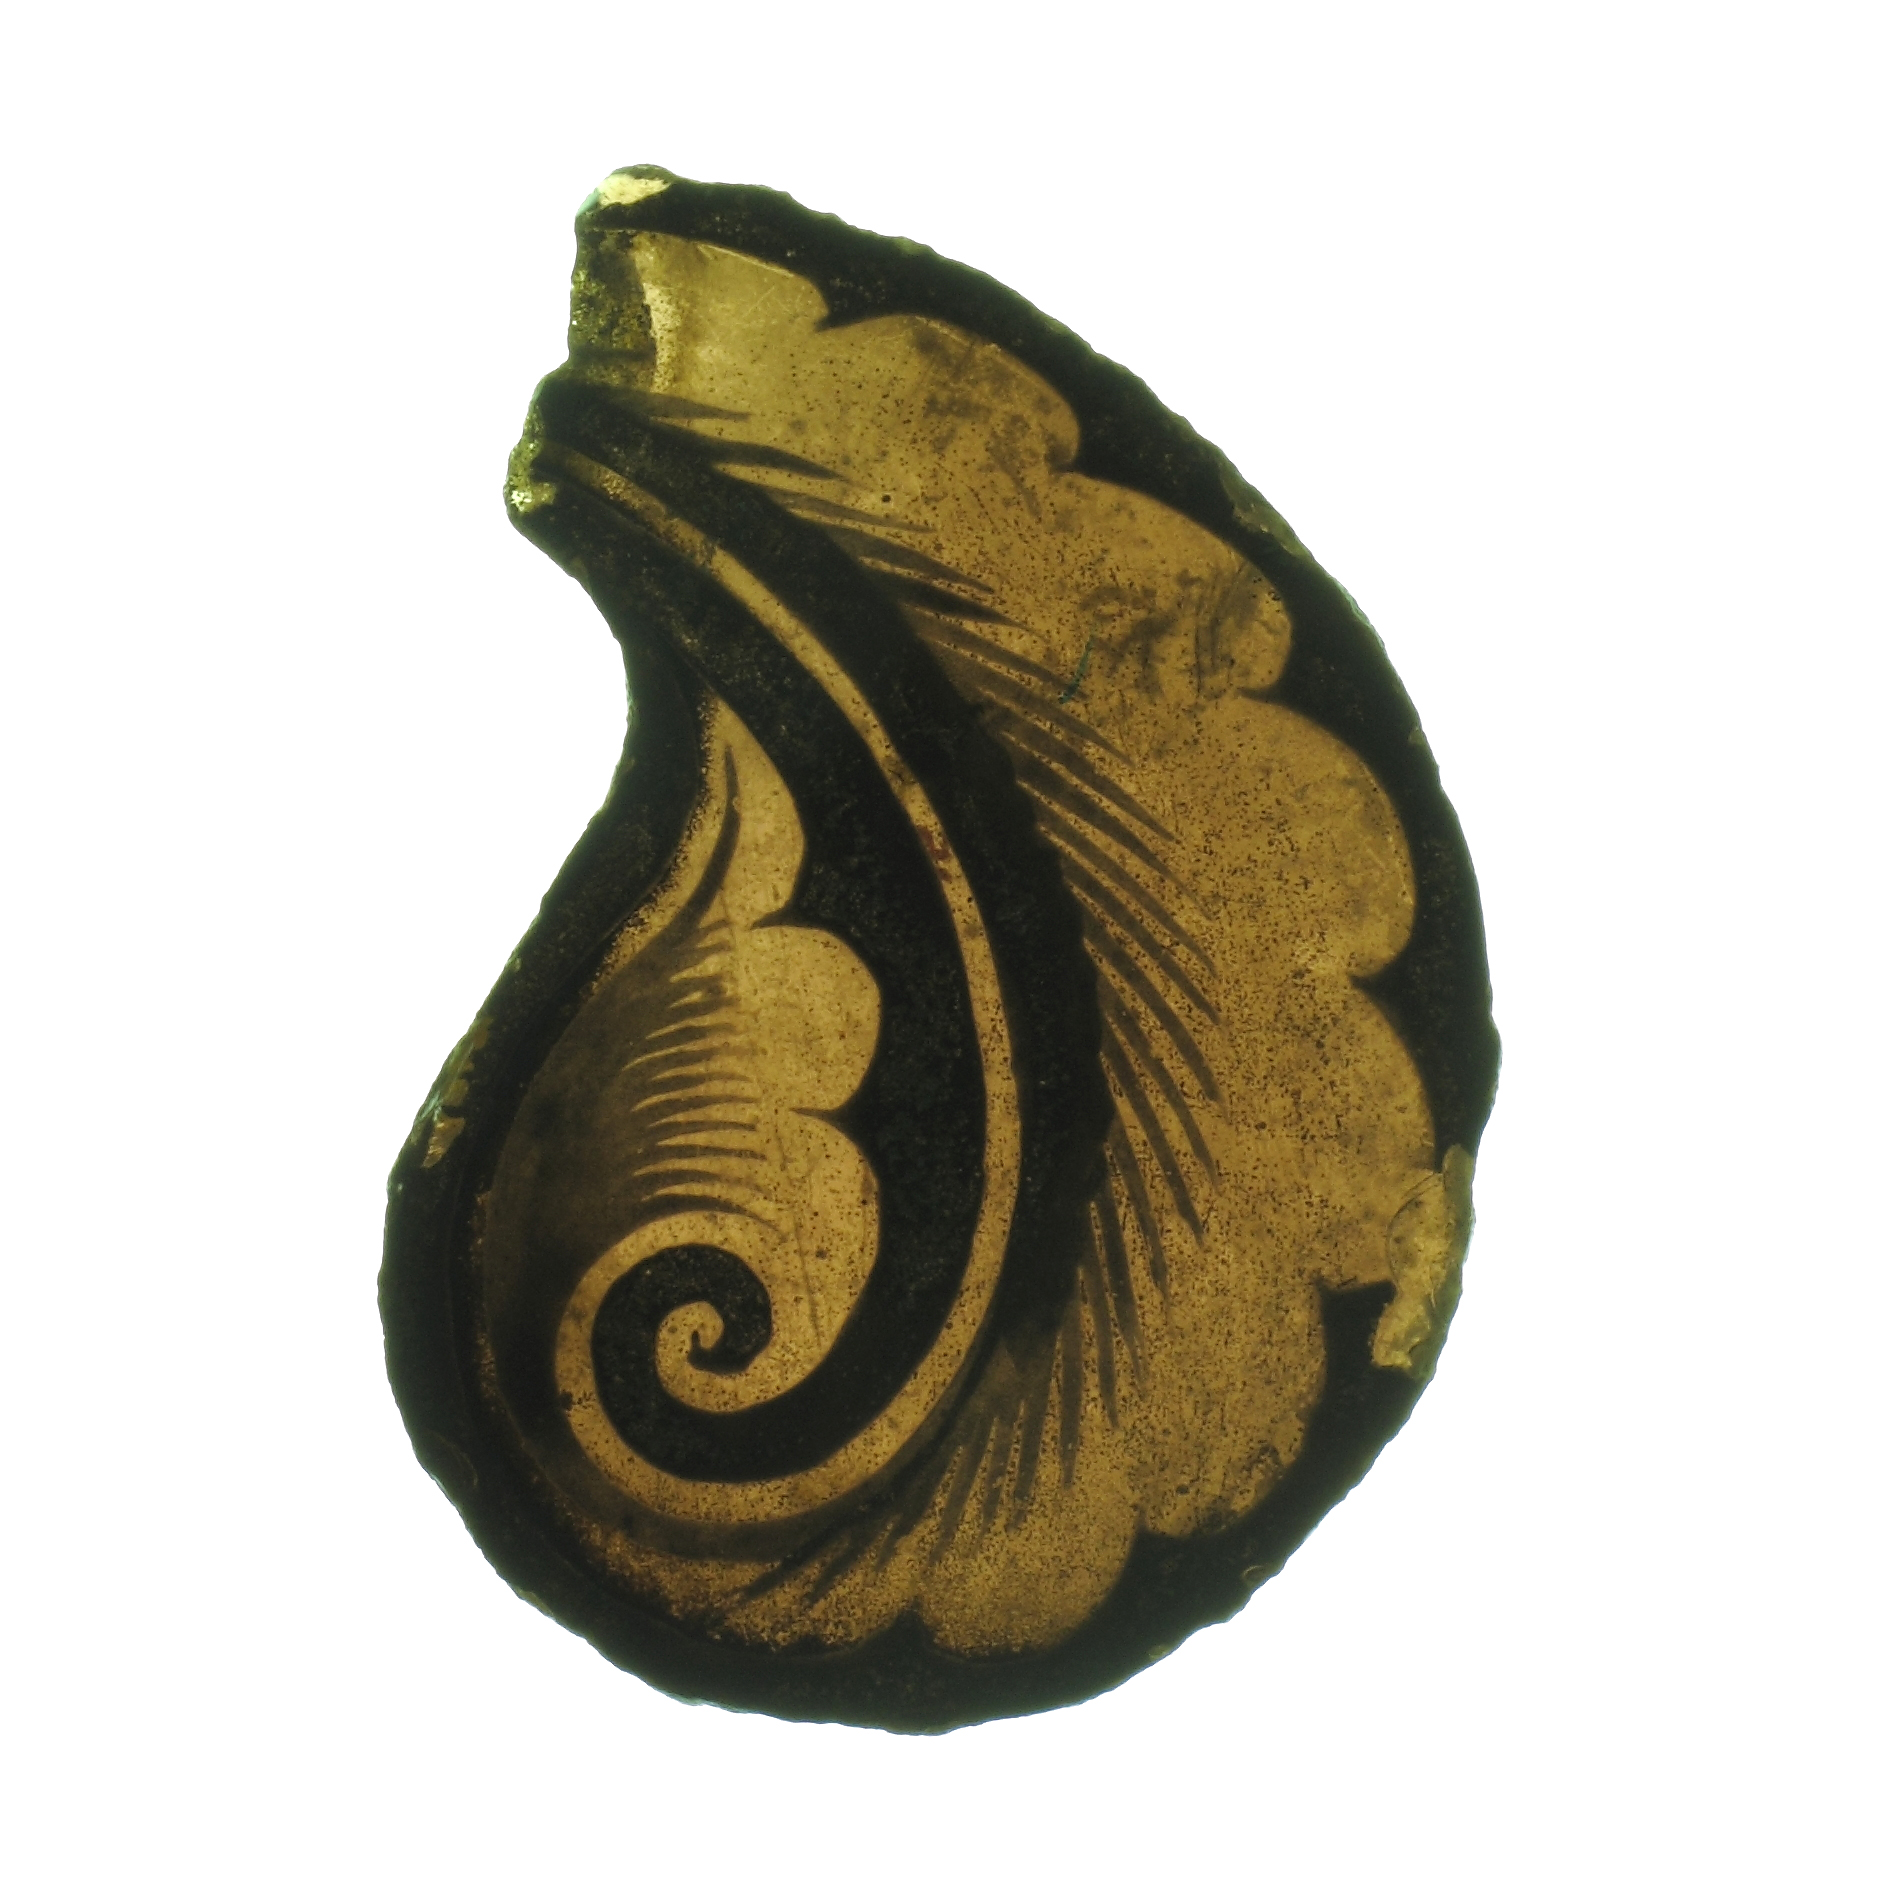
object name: fragment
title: Glass Fragment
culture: french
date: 1101-1400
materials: glass, metal, paint